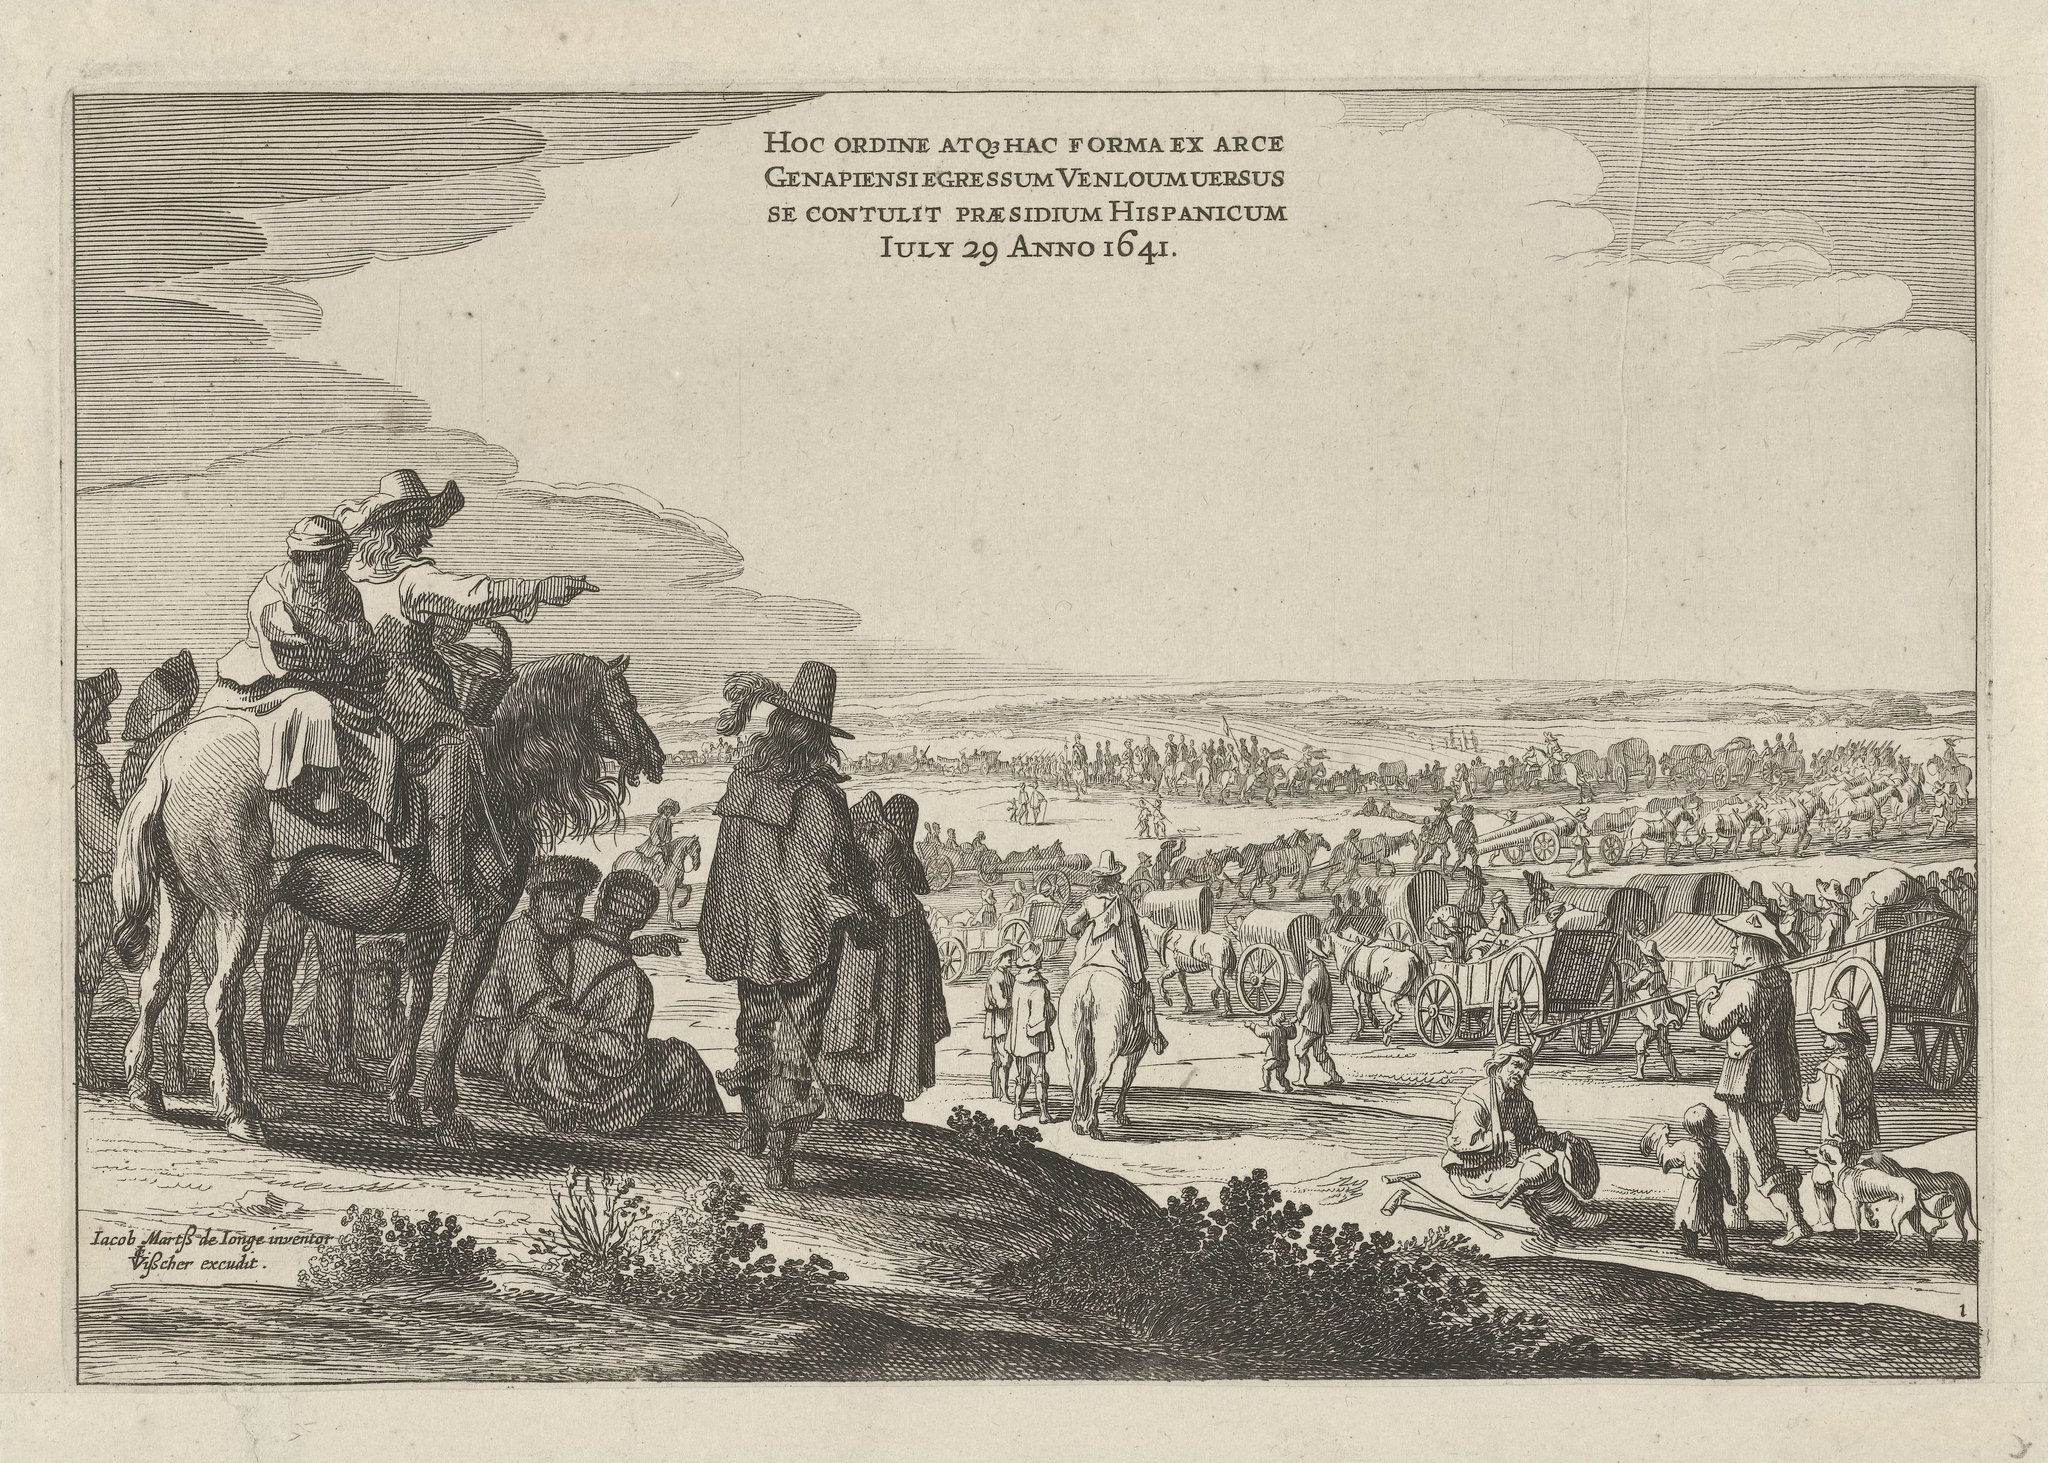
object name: print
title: Hoc ordine atq hac forma ex arce Genapiensi egressum (...)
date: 1641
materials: paper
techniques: engraving, etching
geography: amsterdam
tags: troop movements, transportation, retreat of the defeated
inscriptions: collector's mark: Lugt 240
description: Vertrek van het Spaanse garnizoen uit Huis te Gennep op 29 juli 1641, na het beleg en de verovering van het Huis te Gennep door het Staatse leger onder Frederik Hendrik van 6 juni tot en met 27 juli 1641. Links kijken toeschouwers naar de vertrekkende stoet van wagens en kanonnen. Rechts zit een man met een houten been op de grond. Bovenaan een vierregelige tekst in het Latijn. Prent maakt deel uit van een serie over het vertrek van het Spaanse garnizoen uit Gennep.